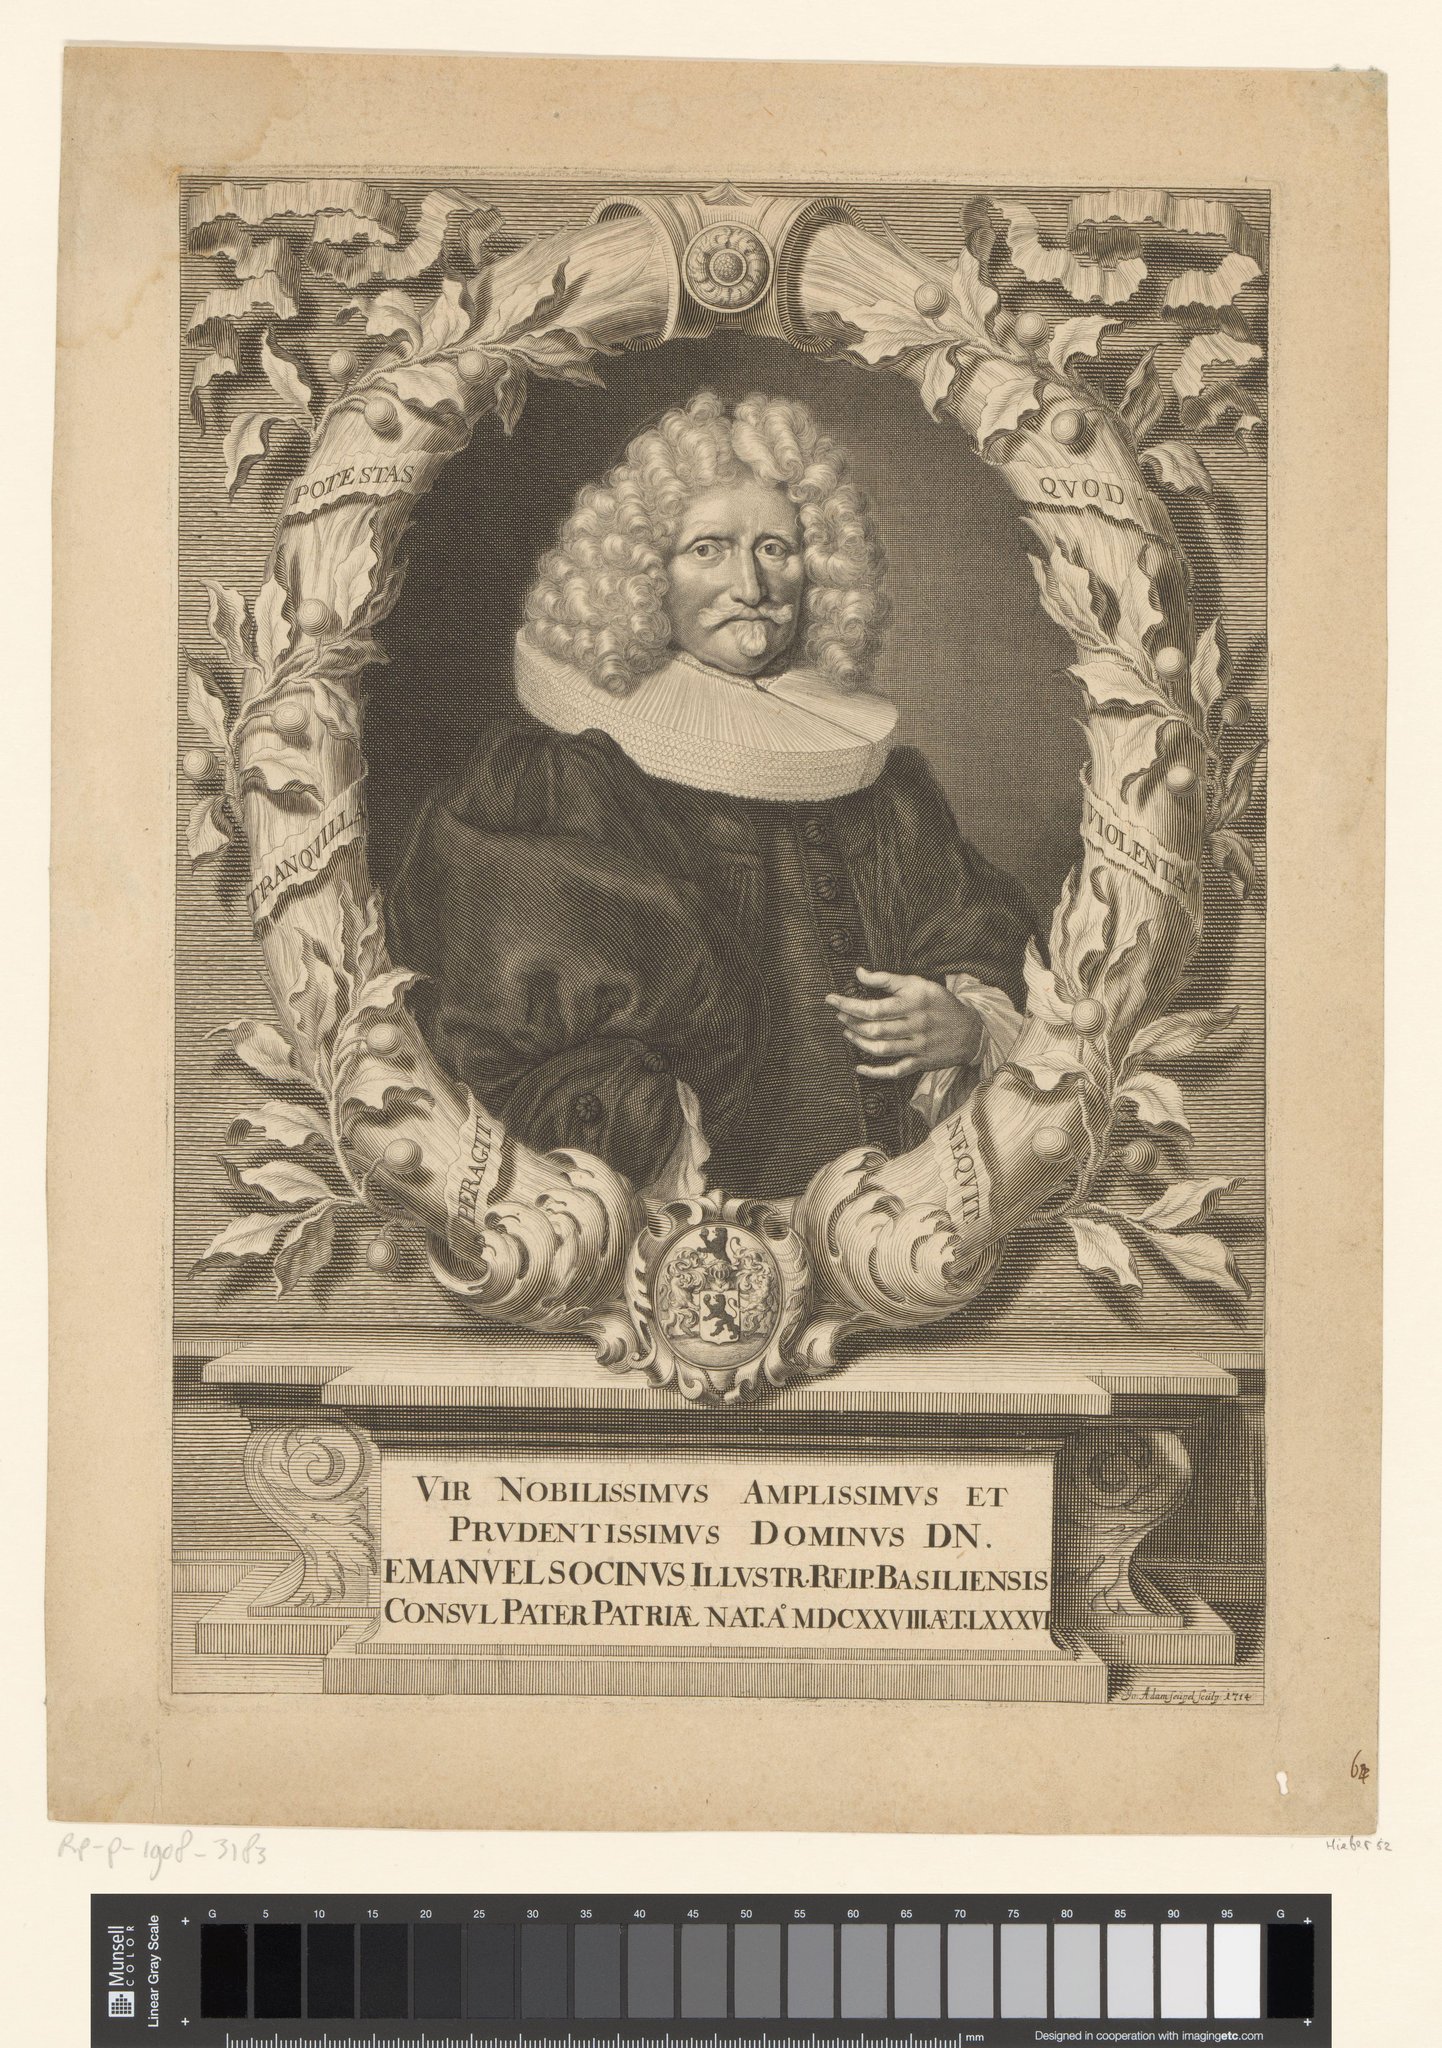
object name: print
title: Portret van Emanuel Socinus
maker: johann adam seupel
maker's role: painter, print maker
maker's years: 1662-1717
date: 1714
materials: paper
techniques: engraving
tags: mayor, historical persons, armorial bearing, heraldry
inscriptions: collector's mark: Lugt 2228